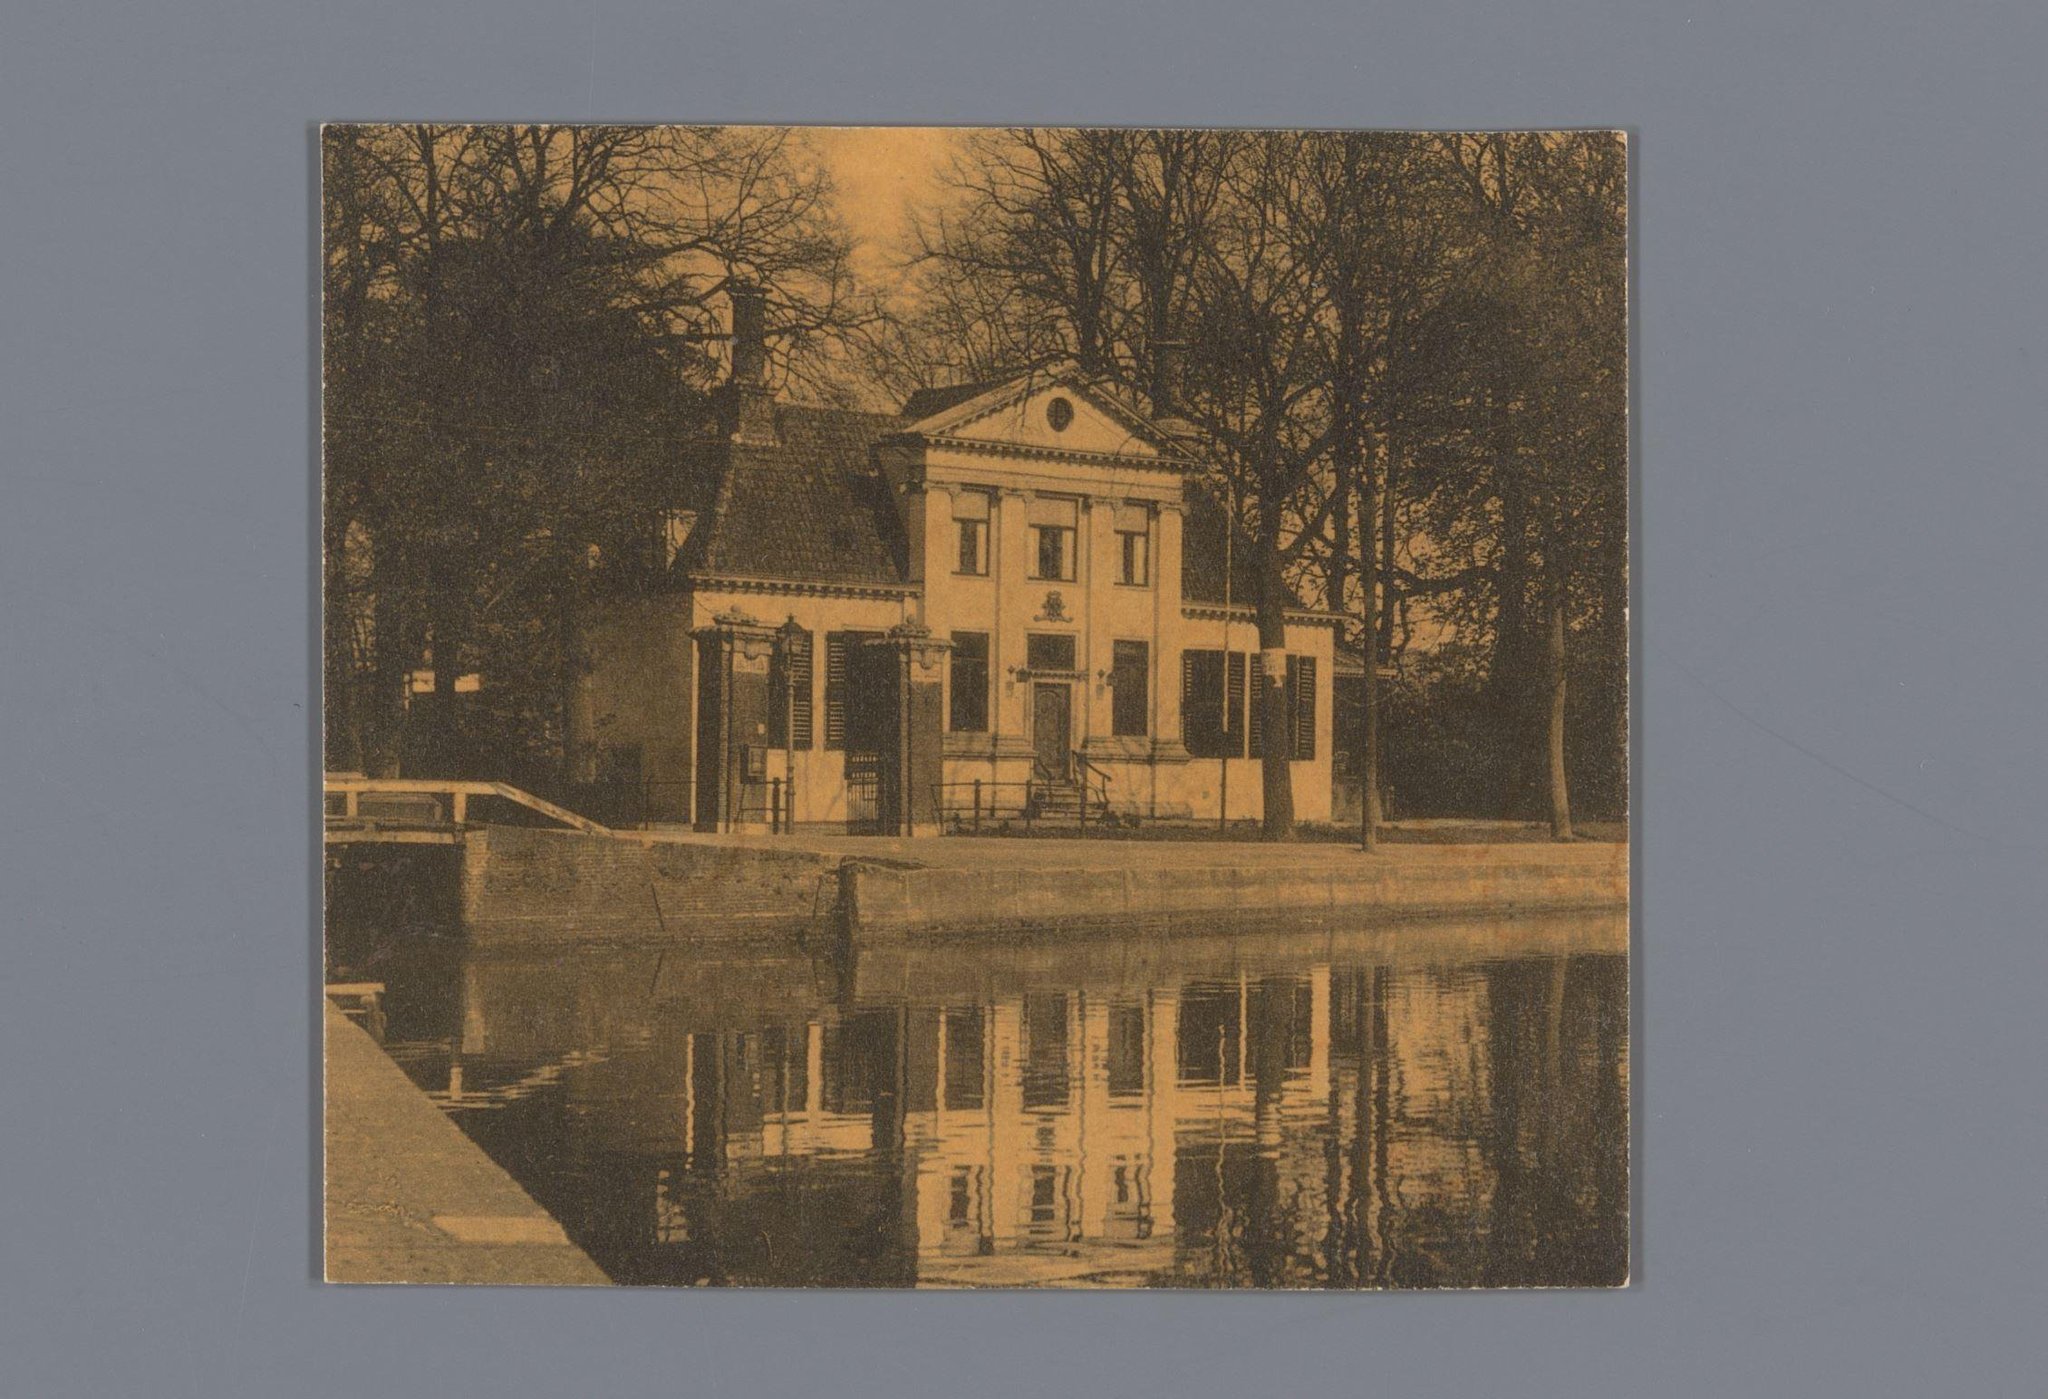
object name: ansichtkaart, prentbriefkaart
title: Gezicht op Huis ten Bosch in Maarssen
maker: Anonymous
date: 1860-1925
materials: paper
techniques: photograph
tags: rural housing, e.g. country-house, villa, cottage, maarssen